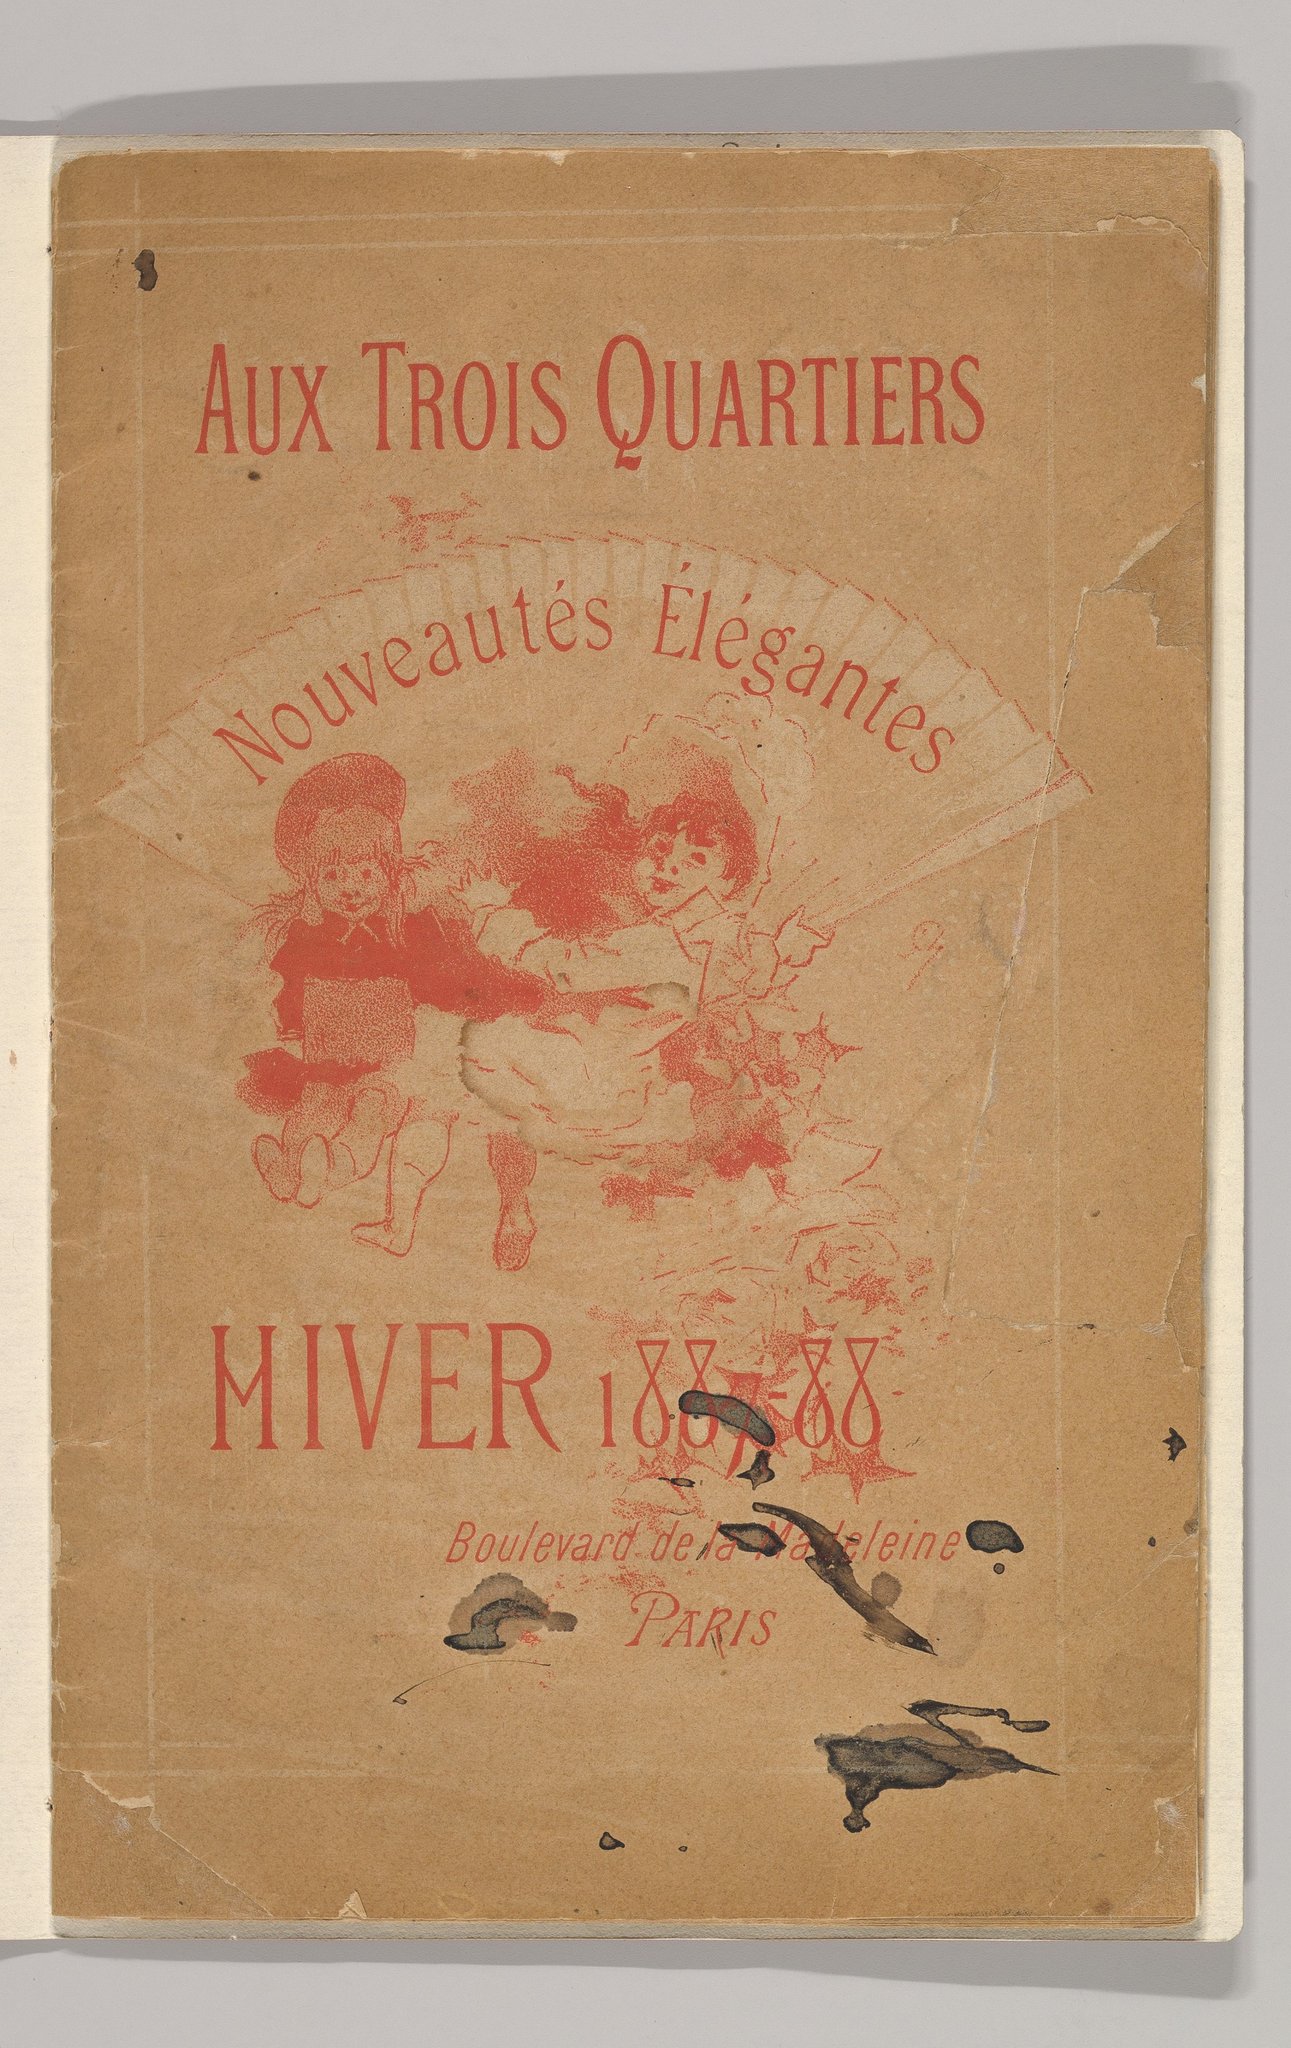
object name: book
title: Aux Trois Quartiers, Nouveautés Élégantes, Hiver 1887–88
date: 1887-1888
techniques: lithograph, engraving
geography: france